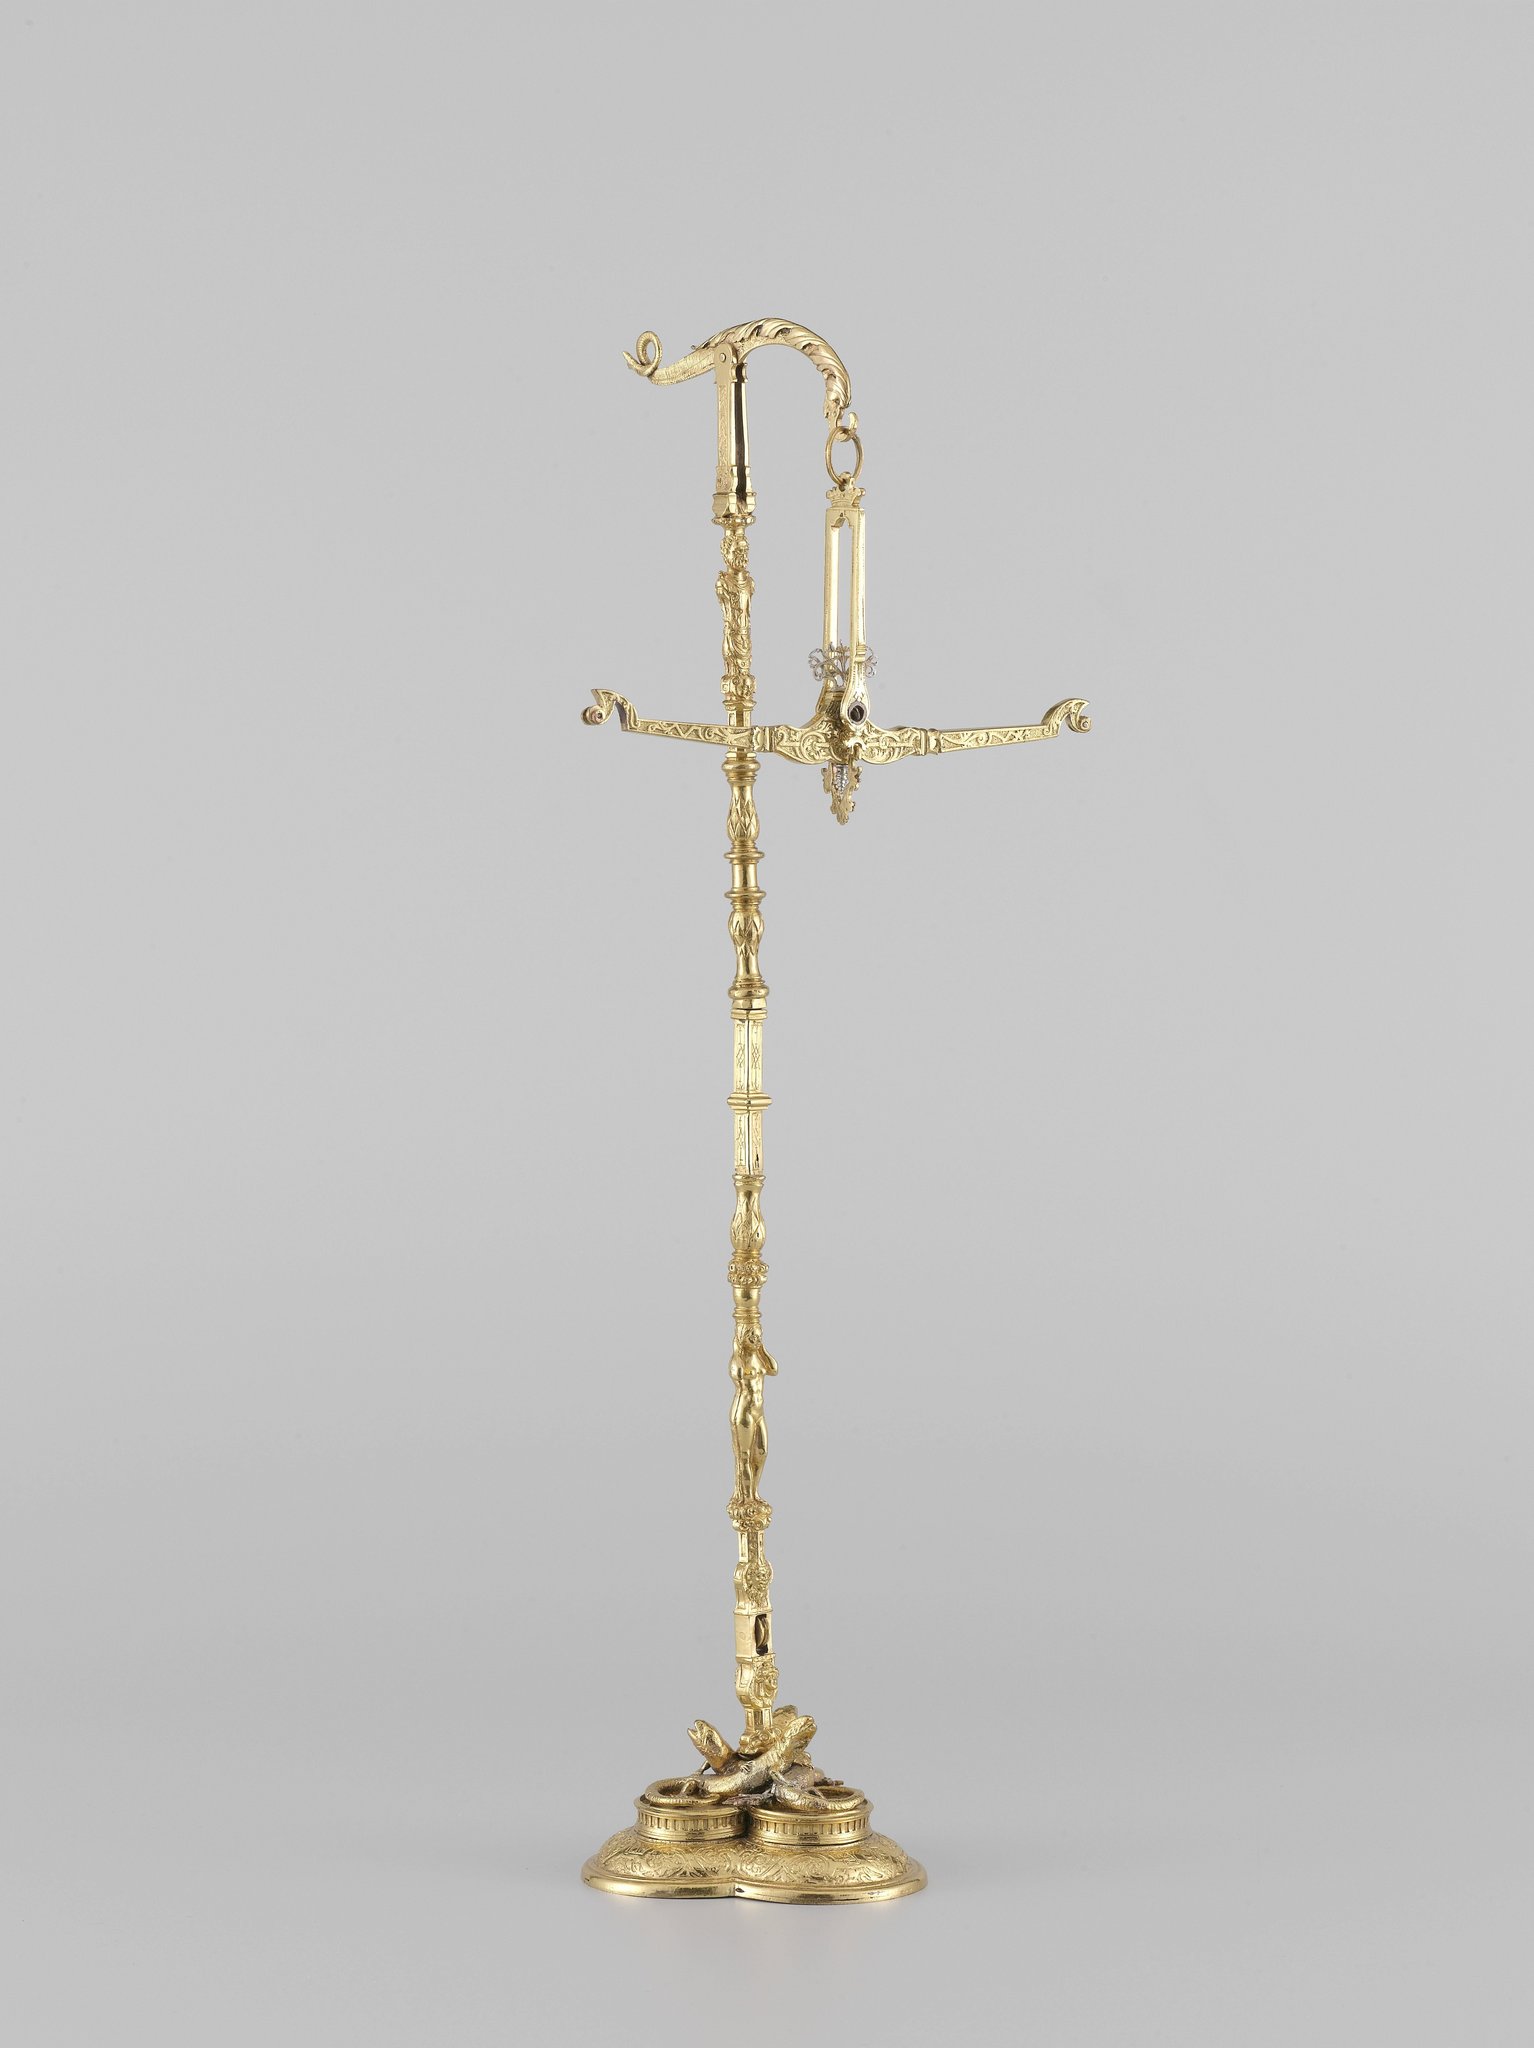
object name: balance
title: Balance standard with a counterweight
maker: wenzel jamnitzer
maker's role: print maker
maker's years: 1508-1585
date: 1560-1570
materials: bronze, silver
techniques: engraving, gilding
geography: nuremberg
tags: ornaments ~ art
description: Originally two little pans hung on long cords from the ends of the lower crosspiece: one for the precious objects to be weighed, and the other for the weights. The counterweight is connected with a cord to the hinge at the top via the little wheel at the bottom of the stem. By sliding the counterweight closer to the foot of the scales, the balance can be adjusted, allowing different metals and precious stones to be weighed.